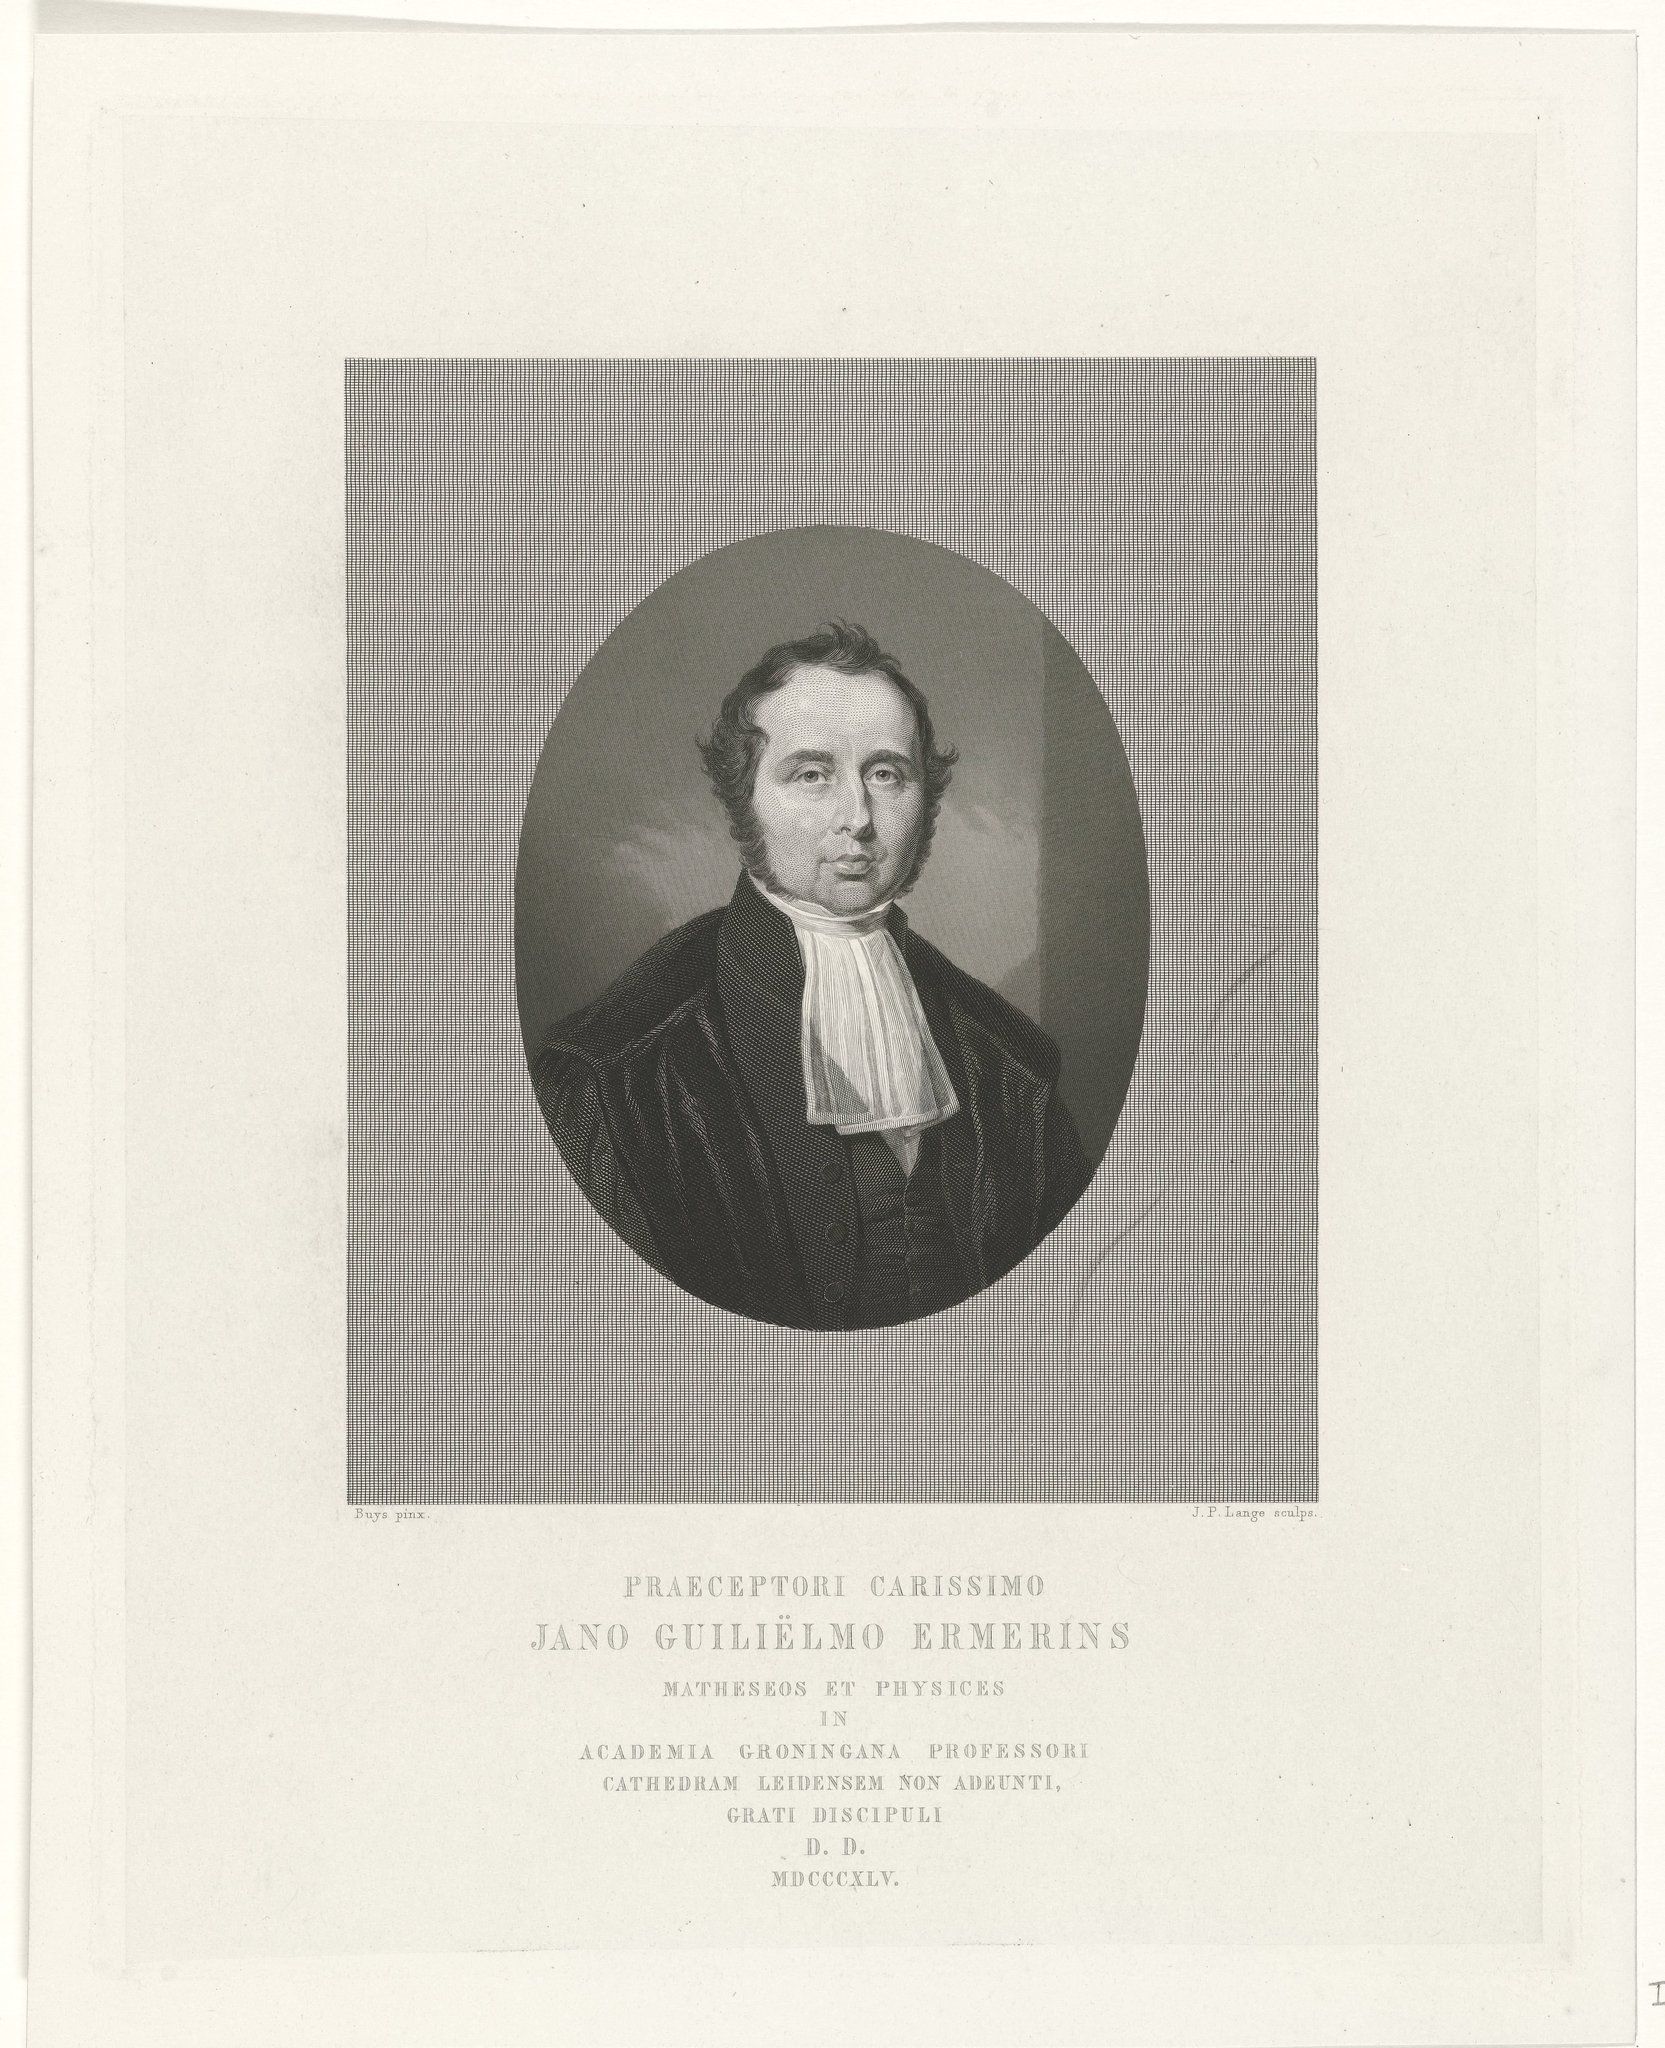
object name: print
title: Praeceptori Carissimo Jano Guiliëlmo Ermerins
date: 1845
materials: paper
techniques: engraving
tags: physicist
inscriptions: collector's mark: Lugt 2228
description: Portretbuste in ovaal naar rechts van Jan Willem Ermerins, hoogleraar in de wiskunde en natuurwetenschappen te Groningen, blootshoofds. Ermerins is gehuld in een toga en draagt een bef. In de marge staat een Latijns onderschrift.